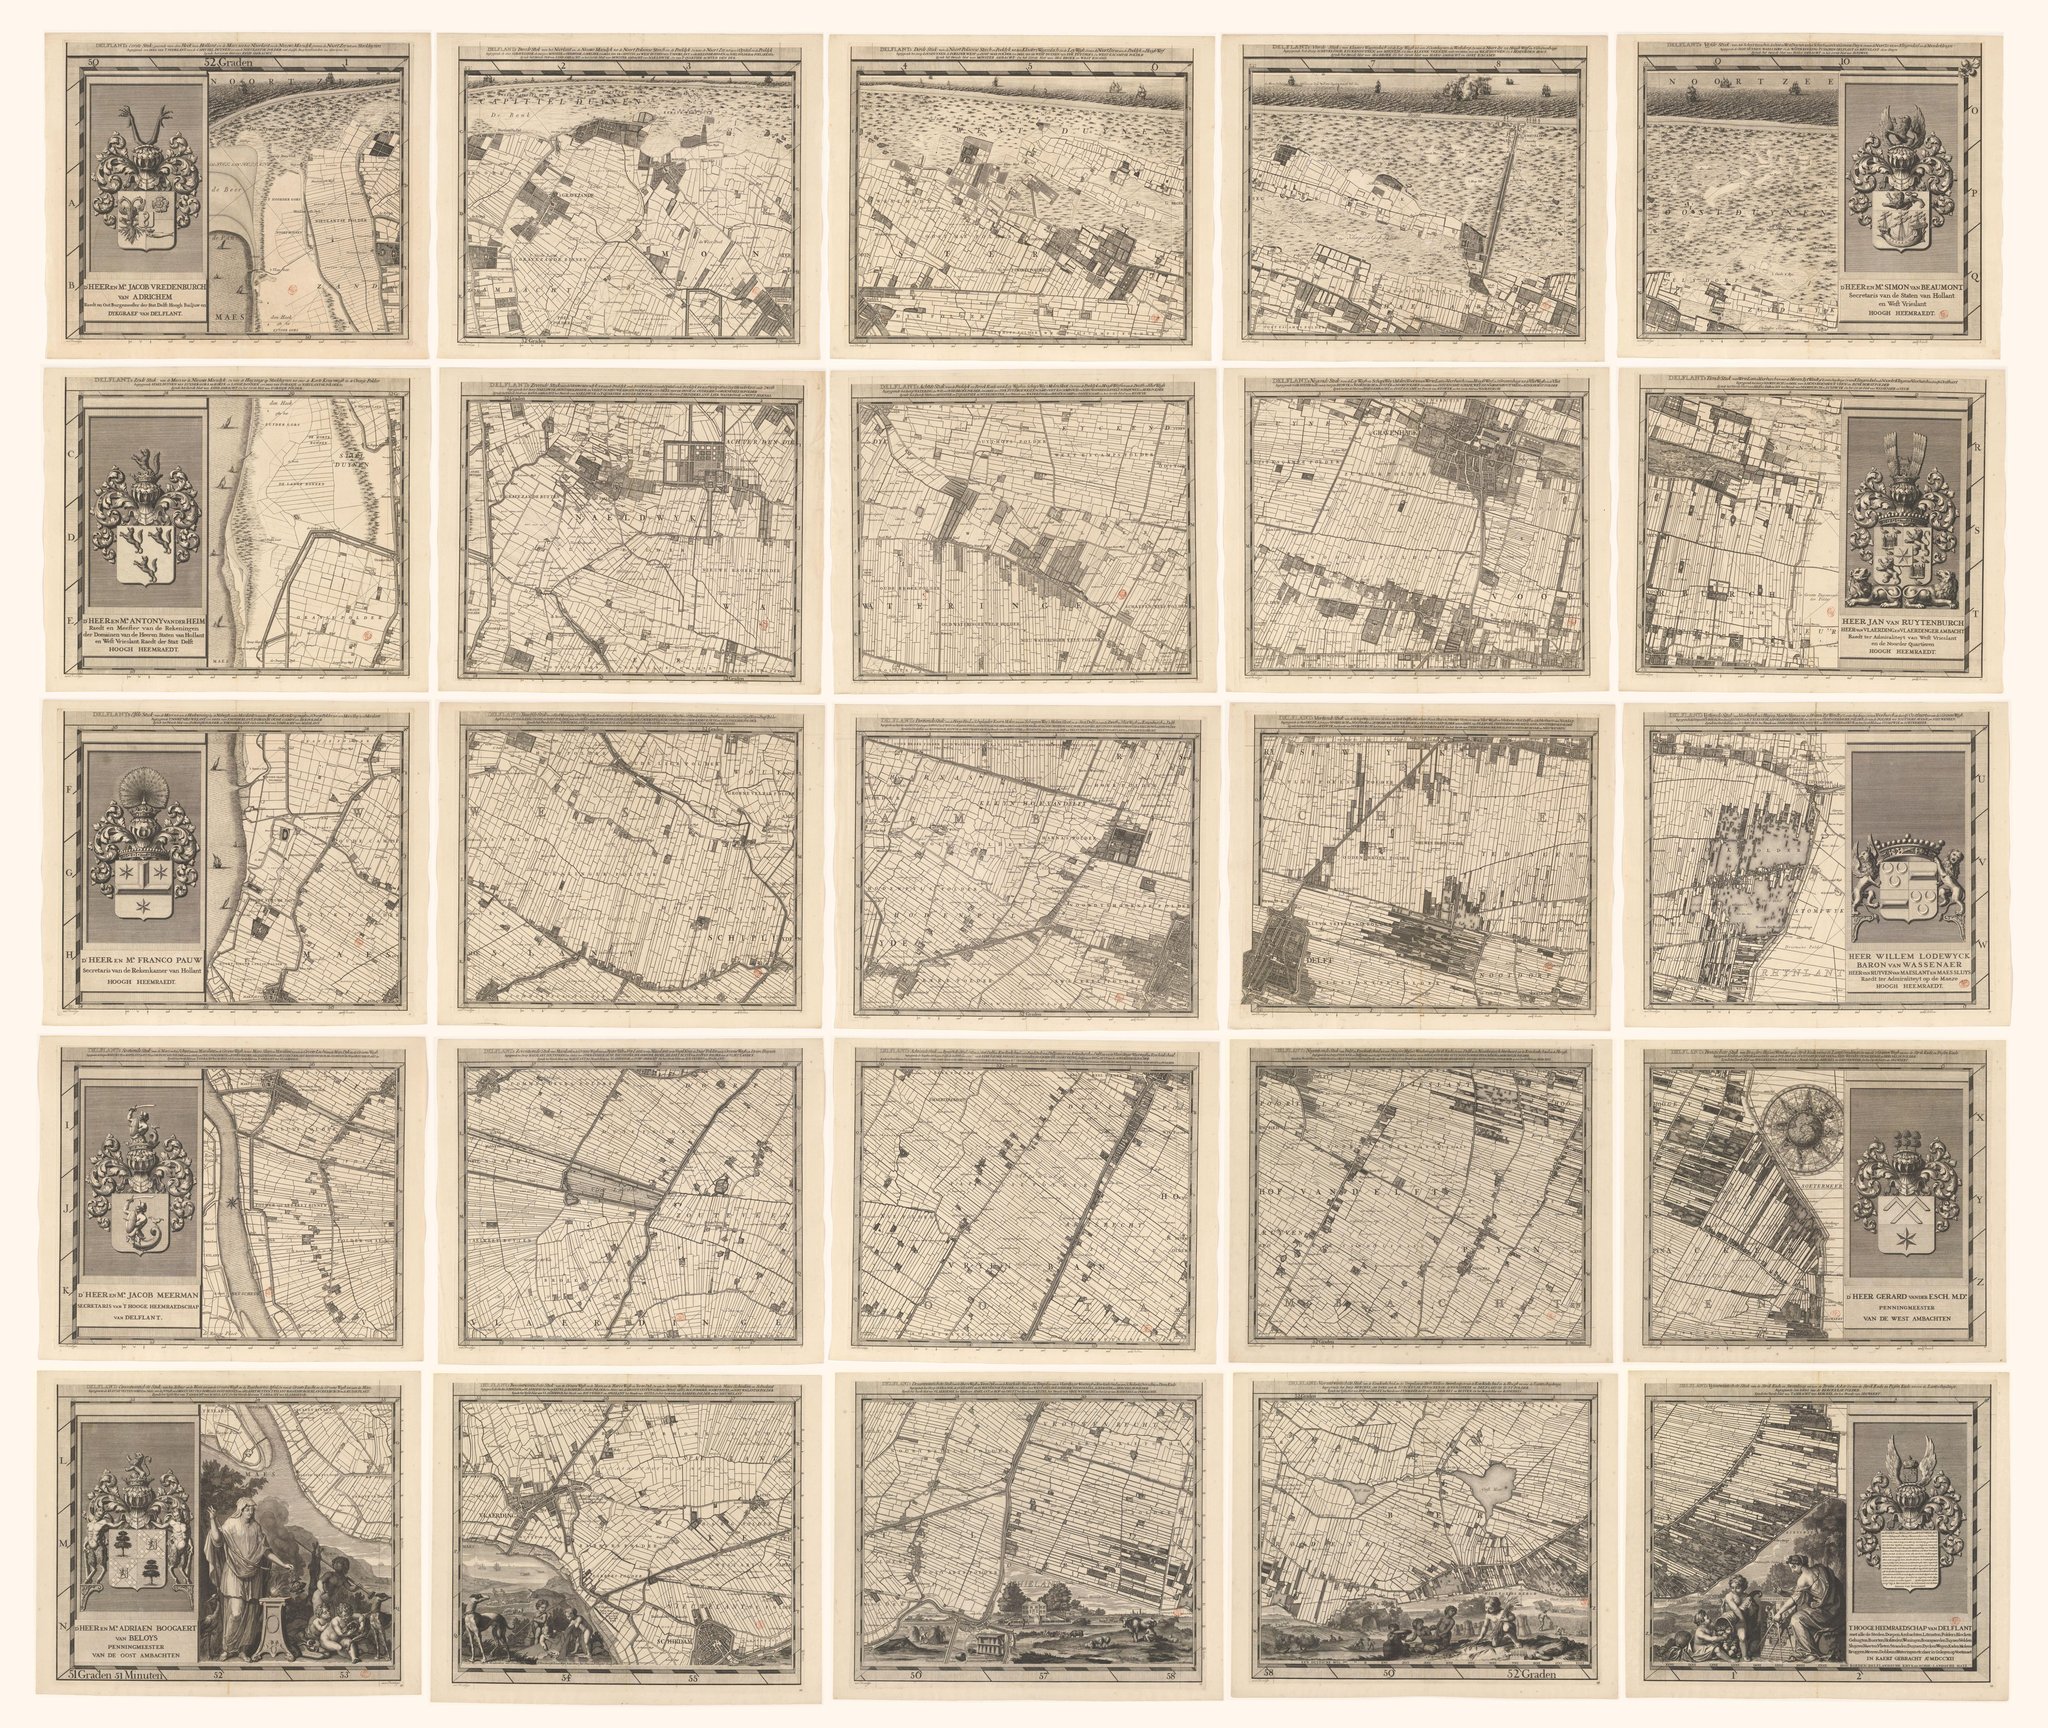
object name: print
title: Kaart van het Hoogheemraadschap van Delfland, bestaande uit vijfentwintig delen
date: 1712-1735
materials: paper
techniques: engraving, etching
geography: delft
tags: commercial fishery, coat of arms (as symbol of the state, etc.), hunting, chase, agriculture, maps of cities, armorial bearing, heraldry, instruments used in geodesy, surveying instruments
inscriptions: collector's mark: Lugt 2228, collector's mark: Lugt 195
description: Dit object is omwille van een betere presentatie virtueel samengevoegd maar bestaat fysiek uit losse onderdelen. Deze kaart bestaat uit vijfentwintig bladen, de bijhorende titelstrook is gedrukt van twee platen. Meerdere prentmakers hebben aan deze kaart gewerkt. In volgorde van meest gewerkte dagen zijn dit: Luggert van Anse (1091 dagen), Thomas Doesburgh (952 dagen), Jacobus Deur (806 dagen), Johannes Deur (683 dagen) en Pieter Sluyter (151 dagen). Sluyter was verantwoordelijk voor de versieringen, de anderen voor de rest. Wie precies aan welk blad heeft gewerkt is niet duidelijk. Pieter Haringh had het ontwerp voor de wapenschilden geleverd en Arnold Houbraken het ontwerp voor de rest van de versieringen. Het drukken, uitgeven en verkopen van de kaart lag, zoals blijkt uit het privilege, in handen van het hoogheemraadschap. Voor zover bekend is de kaart in zijn geheel twee keer gedrukt, in 1712 en 1735. Het hoogheemraadschap beheerde de voorraad kaarten voor verkoop. In een aantal atlassen van Covens & Mortier (Nieuwe atlas inhoudende de vier gedeeltens der waereld (...). 5 delen. Amsterdam: Covens & Mortier, s.a. [1721-1759], dl. 3) zijn de zevenentwintig bladen van de kaart en de overzichtskaart opgenomen. Het is dus vermoedelijk niet zo dat de kaart voor deze atlassen opnieuw werd gedrukt. Waarschijnlijk werd een aantal exemplaren bij het hoogheemraadschap afgenomen. Voor de overzichtskaart (verkleinde versie van deze kaart) zie RP-P-AO-11-6-2. Voor een van de twee bladen van de titelstrook zie RP-P-AO-11-7-26.